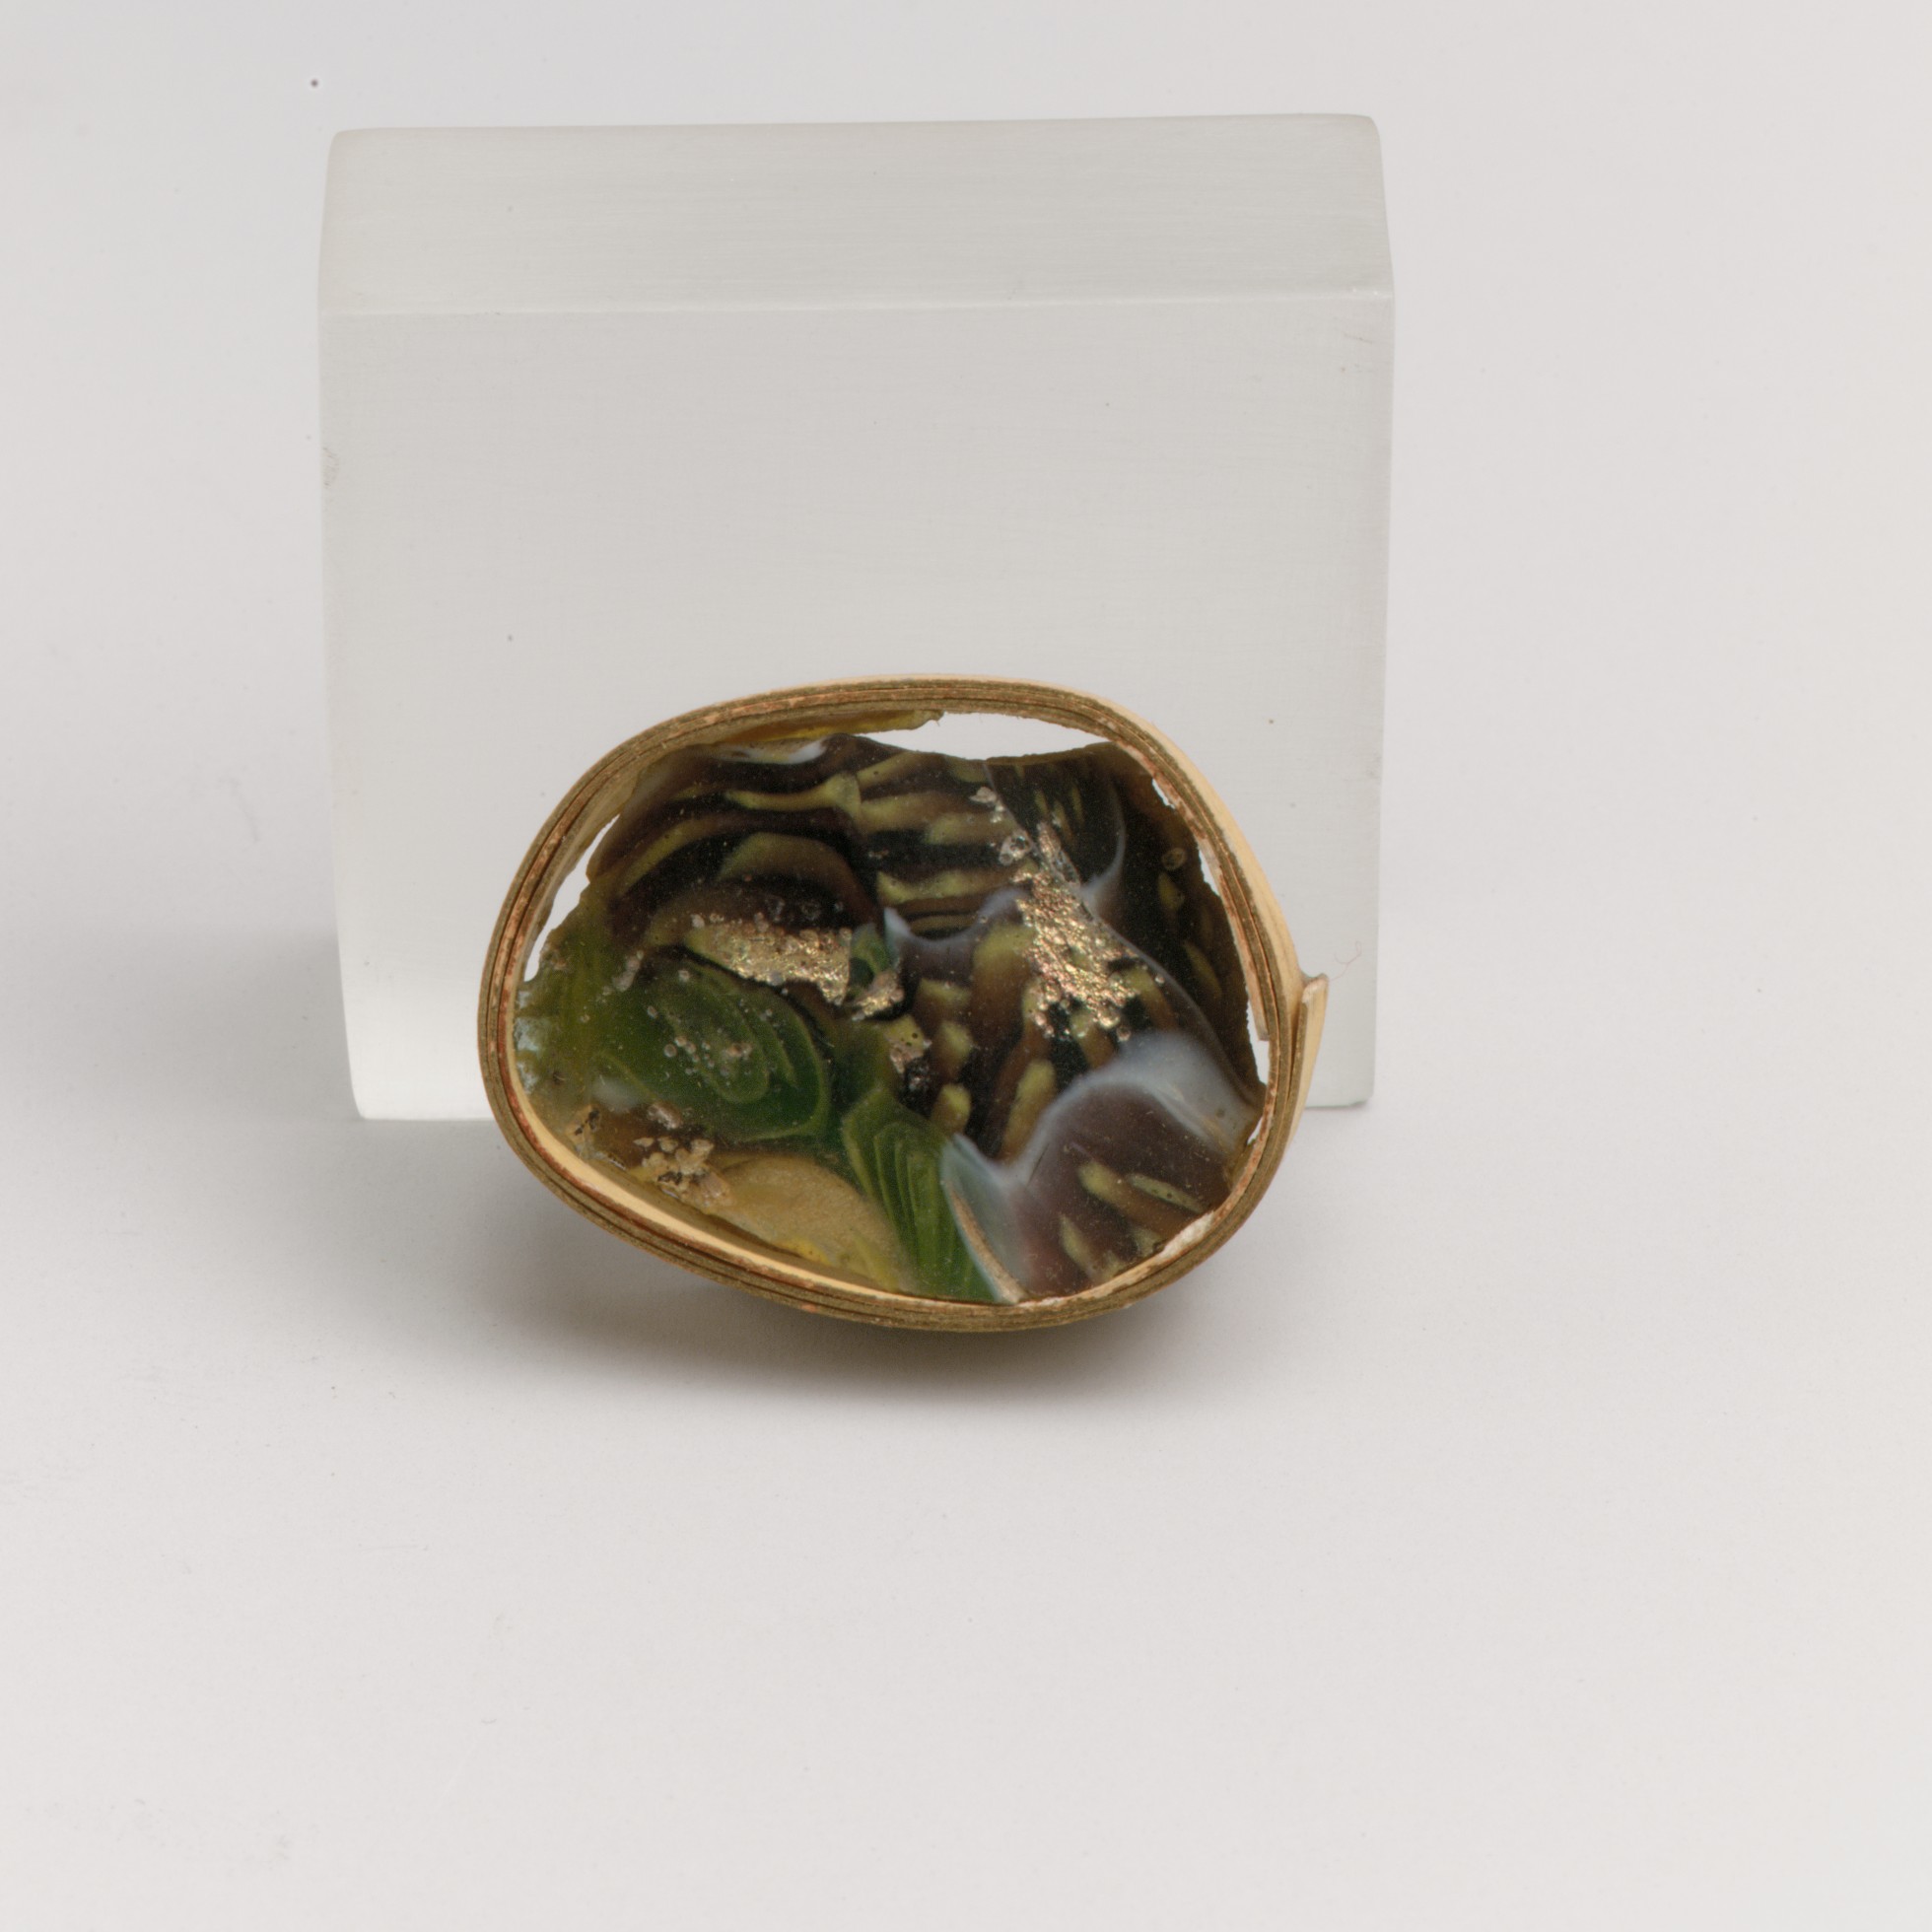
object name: fragment, mosaic bowl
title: Glass mosaic carinated bowl fragment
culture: roman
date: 34 BCE-33 CE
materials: glass